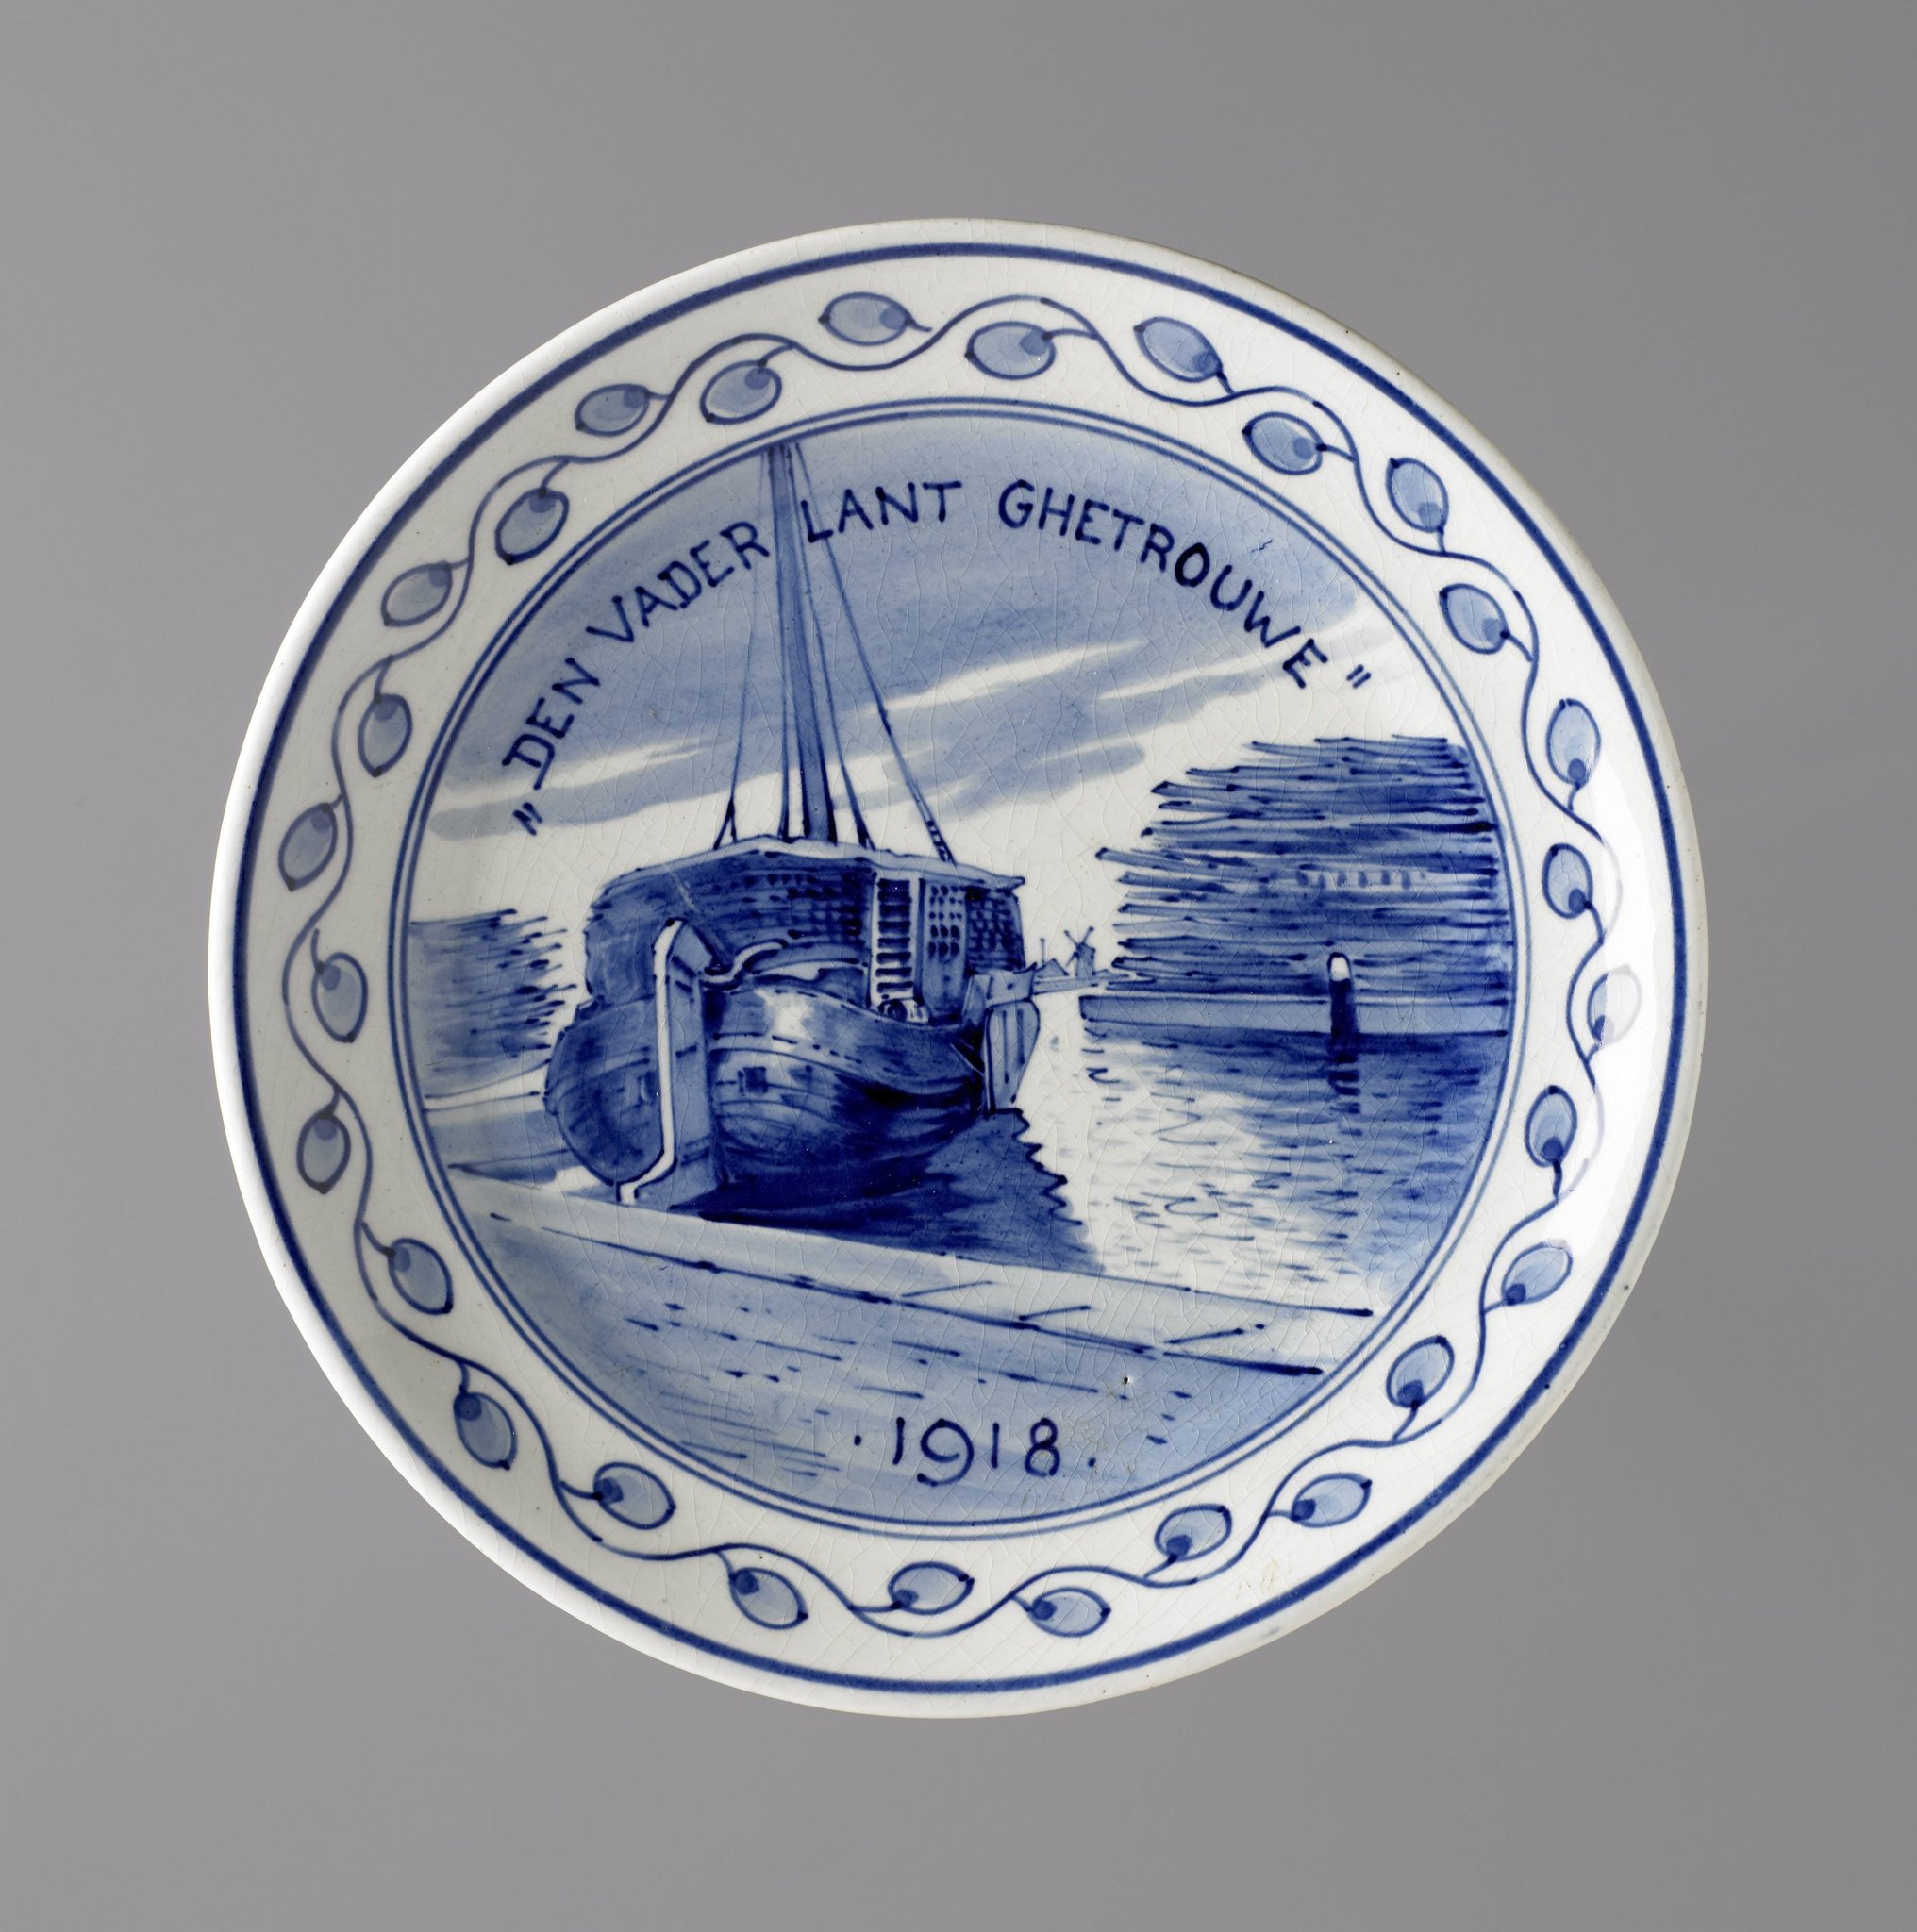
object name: herinneringsbord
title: Den vaderlant ghetrouwe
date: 1918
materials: earthenware, glaze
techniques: painted, vitrification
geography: delft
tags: eerste wereldoorlog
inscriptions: mark: ‘AV 245’, date: ‘1918’, title: ‘"DEN VADERLANT GHETROUWE"’, factory mark: ‘JT Delft’, check stamp: ‘VZK’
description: Bord, blauw geschilderd met afbeelding van een schip aan de kade. Met opschrift. Achterzijde drie blauwe randen en v.z.v. twee gaatjes en ijzerdraad om bord op te hangen. Gemerkt.